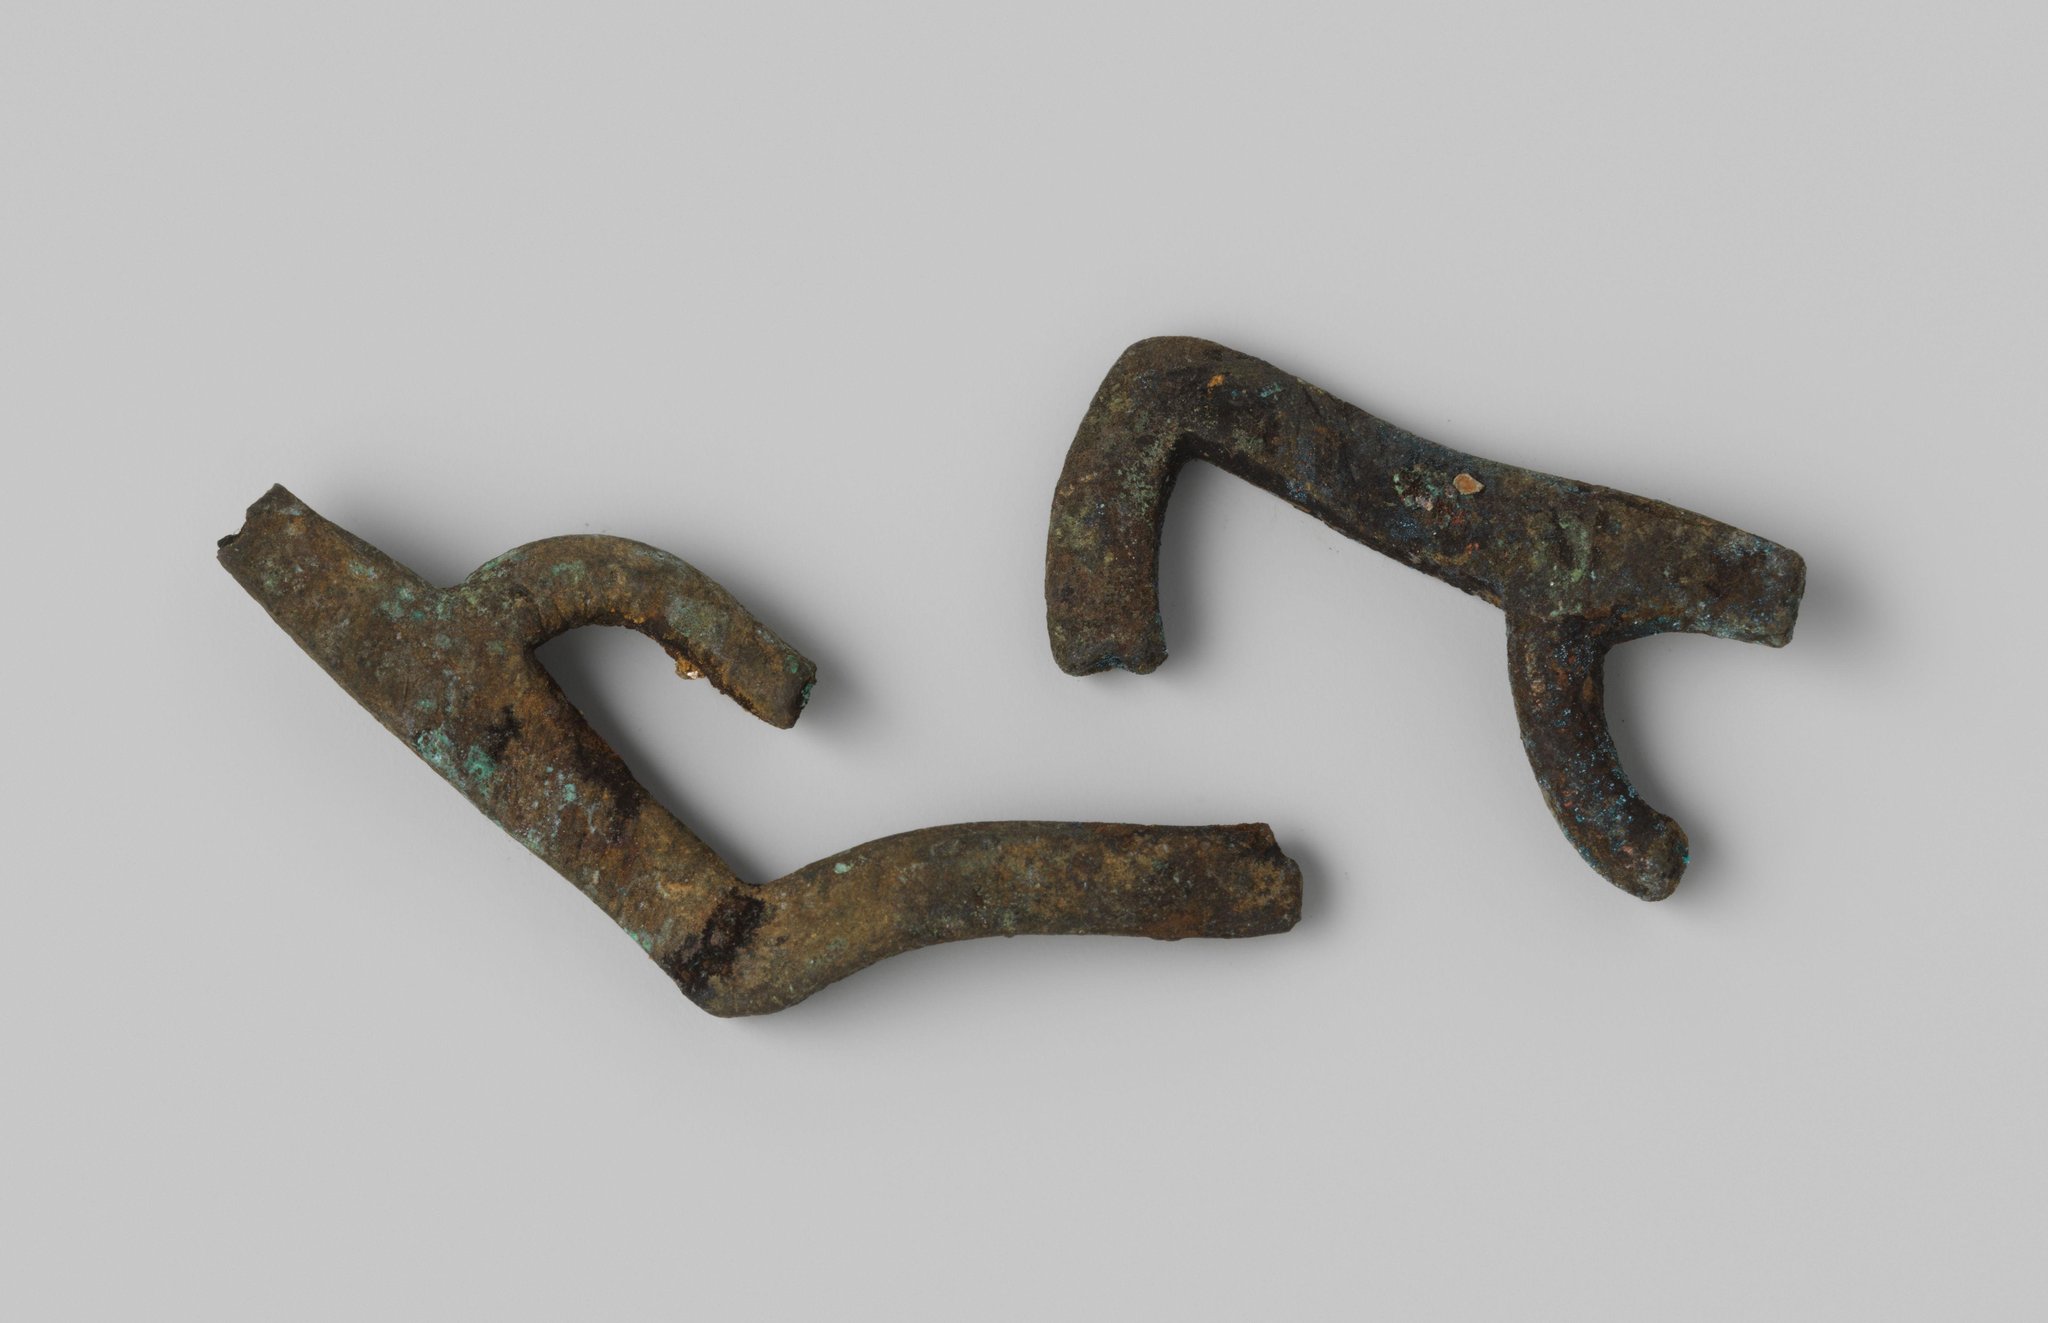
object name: belt buckle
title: Fragmenten riemgesp uit het wrak van de Oost-Indiëvaarder Hollandia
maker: Anonymous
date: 1700-1743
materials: copper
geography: netherlands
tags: verenigde oostindische compagnie, hollandia (schip), annet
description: D-shaped with pointed side, fragm ring, id. NG 1980-27H384, belt buckle.